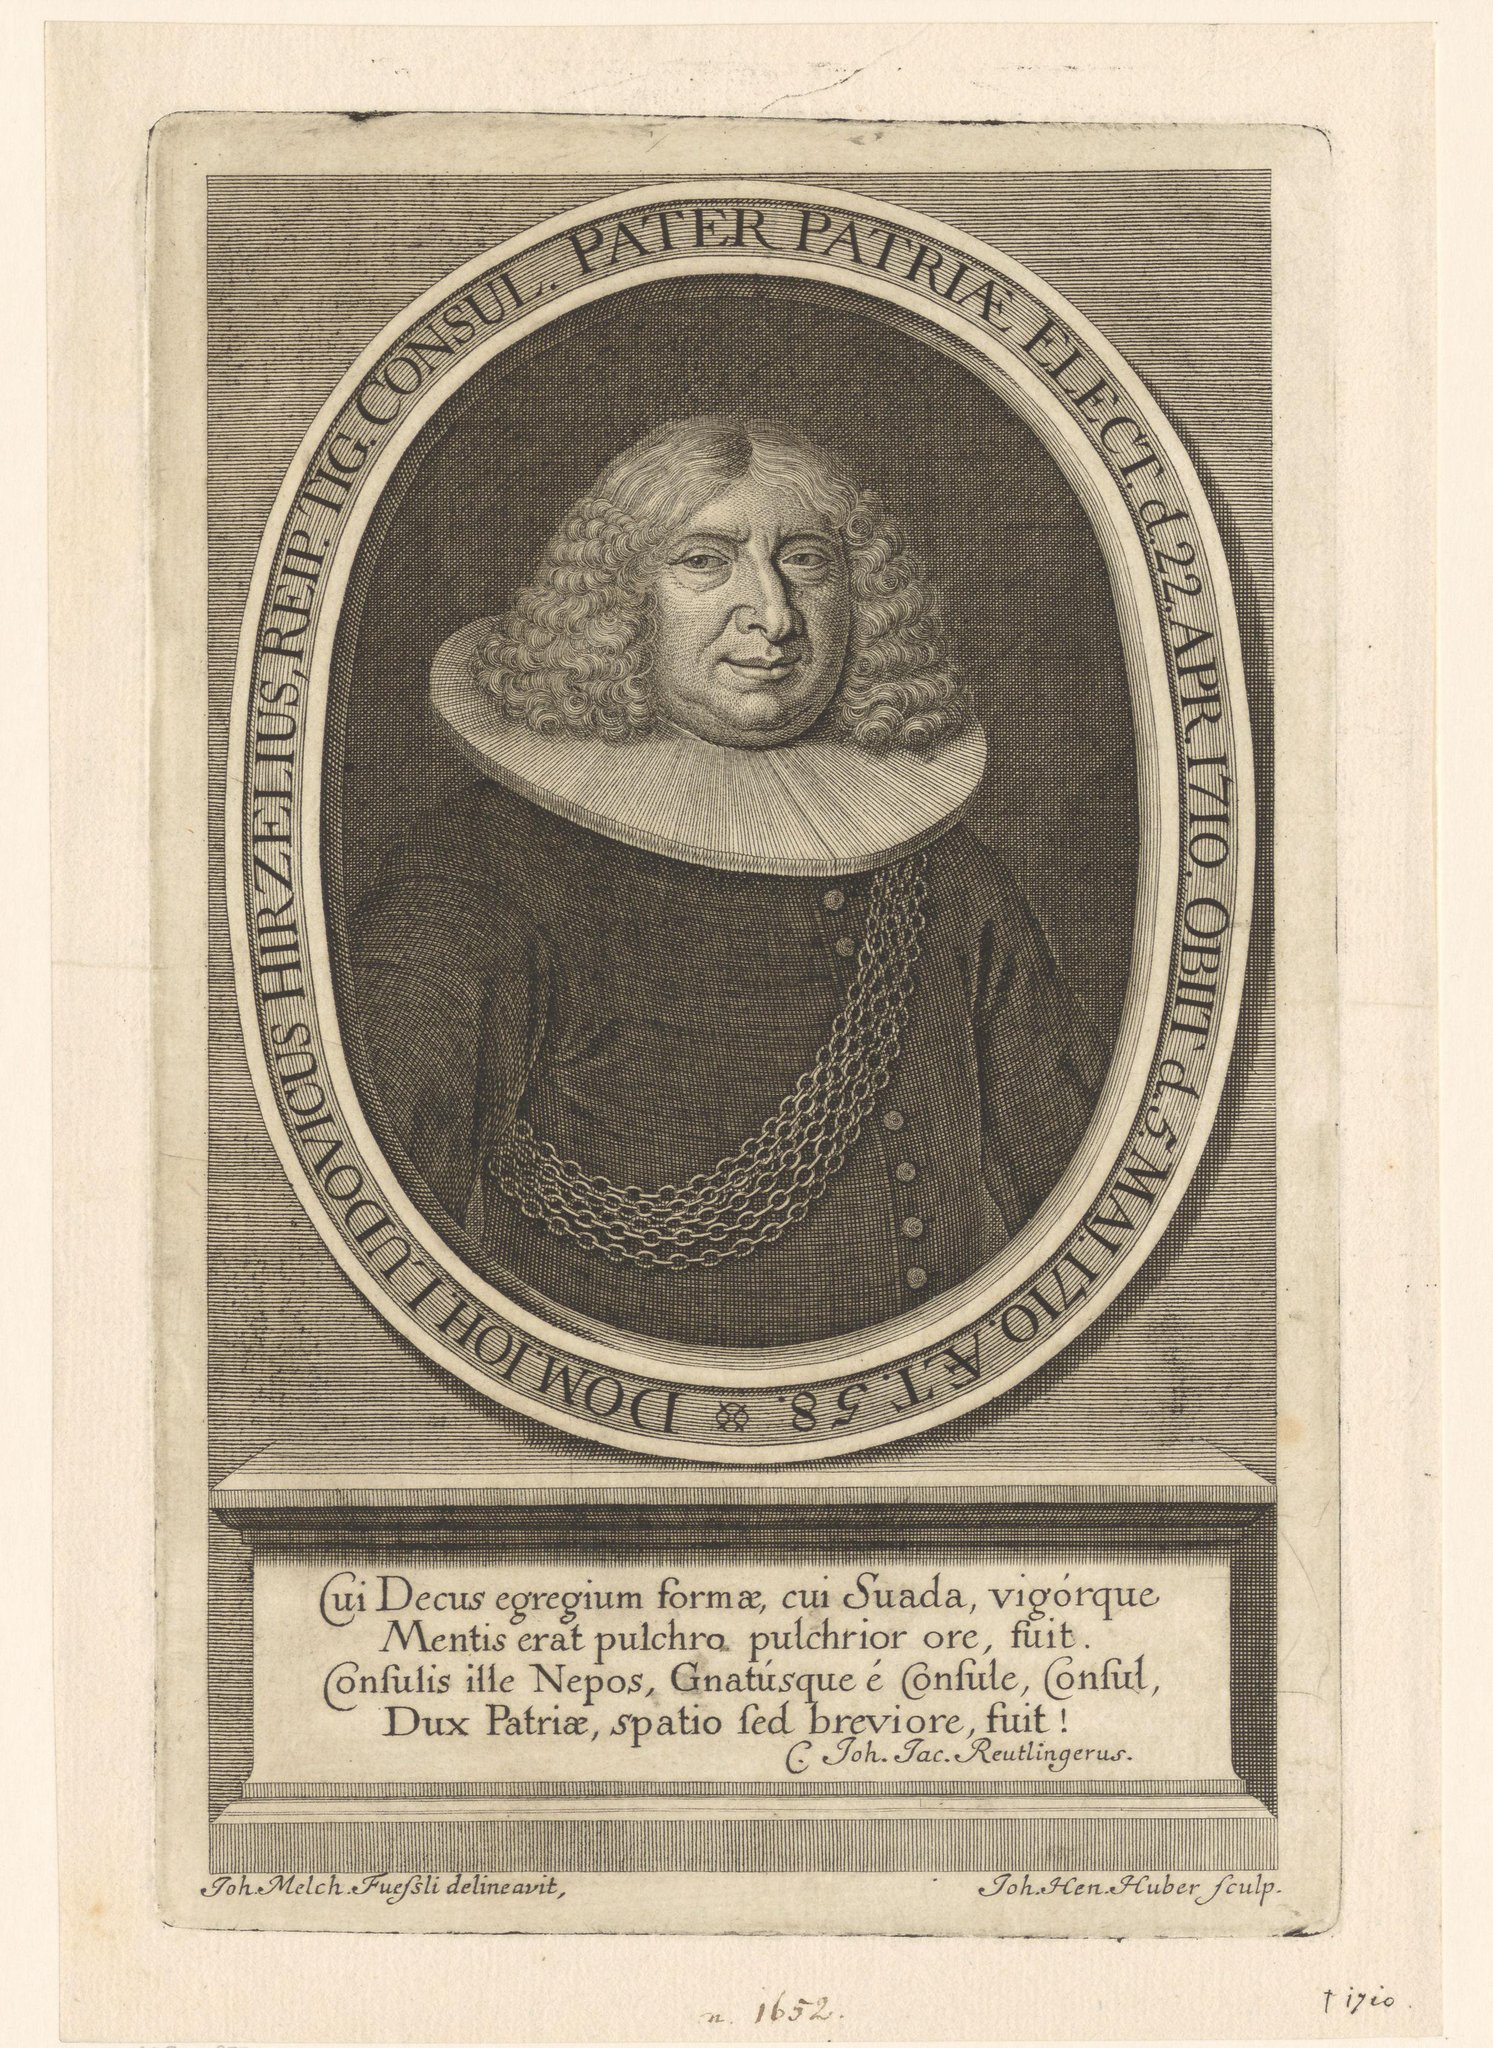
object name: print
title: Portret van Hans Ludwig Hirzel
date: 1710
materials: paper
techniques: engraving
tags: mayor, ornament ~ medallion, historical persons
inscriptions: collector's mark: Lugt 2228, annotation: ‘n. 1652’